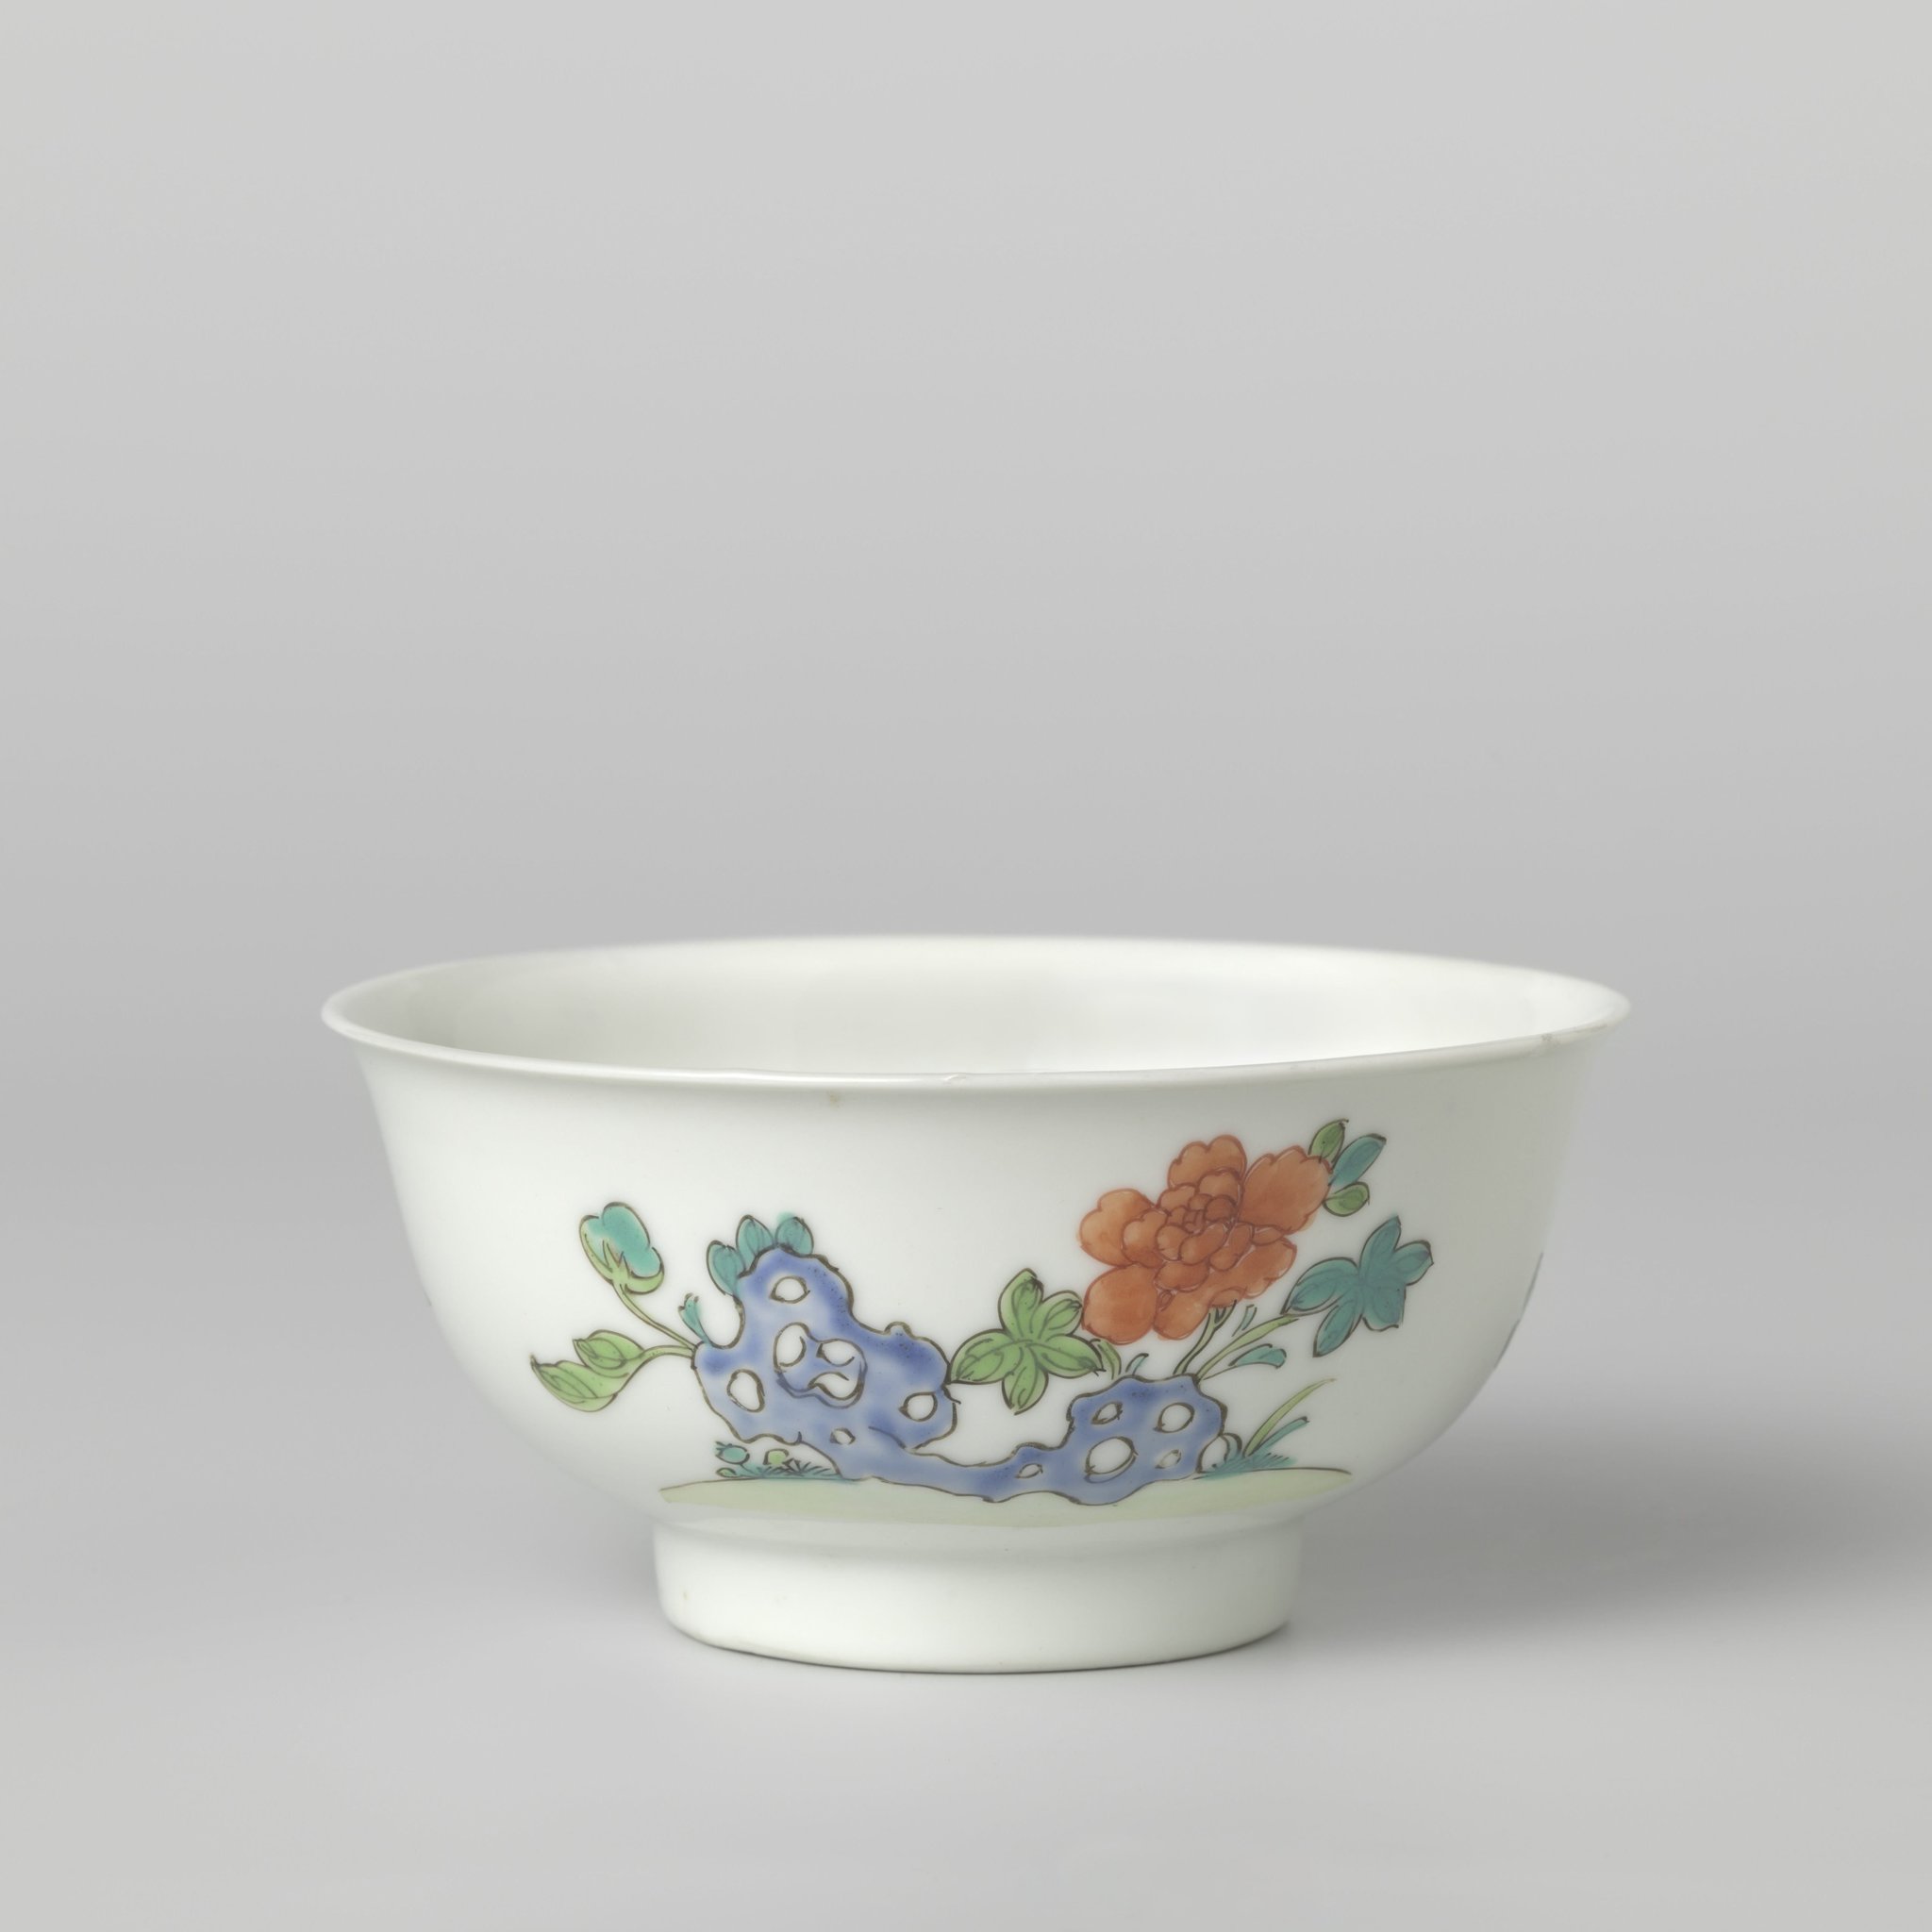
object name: bowl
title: Bell-shaped bowl with flower sprays and a flowering plant near a rock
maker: Anonymous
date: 1800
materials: glaze, gold, paint, porcelain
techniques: firing, gilding, turning, vitrification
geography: china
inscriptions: mark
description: Klokvormige kom van porselein, beschilderd in onderglazuur blauw en op het glazuur blauw, rood, groen, geel, zwart en goud. Op de buitenwand aan de ene kant een chrysanttak en een bamboetak, de andere kant met een bloeiende pioenplant bij een rots. Gemerkt op de onderzijde met een zegelmerk in een dubbele cirkel. Een chip in de rand; enkele chips in de onderzijde. Famille verte.